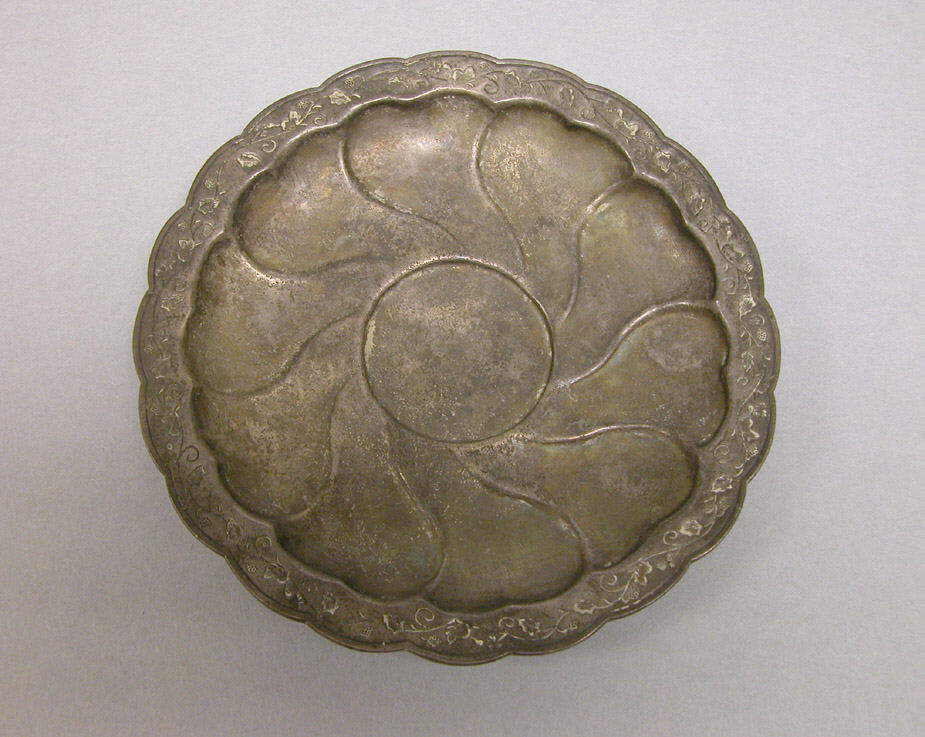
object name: saucer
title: Saucer with Floral Scrolls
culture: chinese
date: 1167-1200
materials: silver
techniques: chasing, repoussé